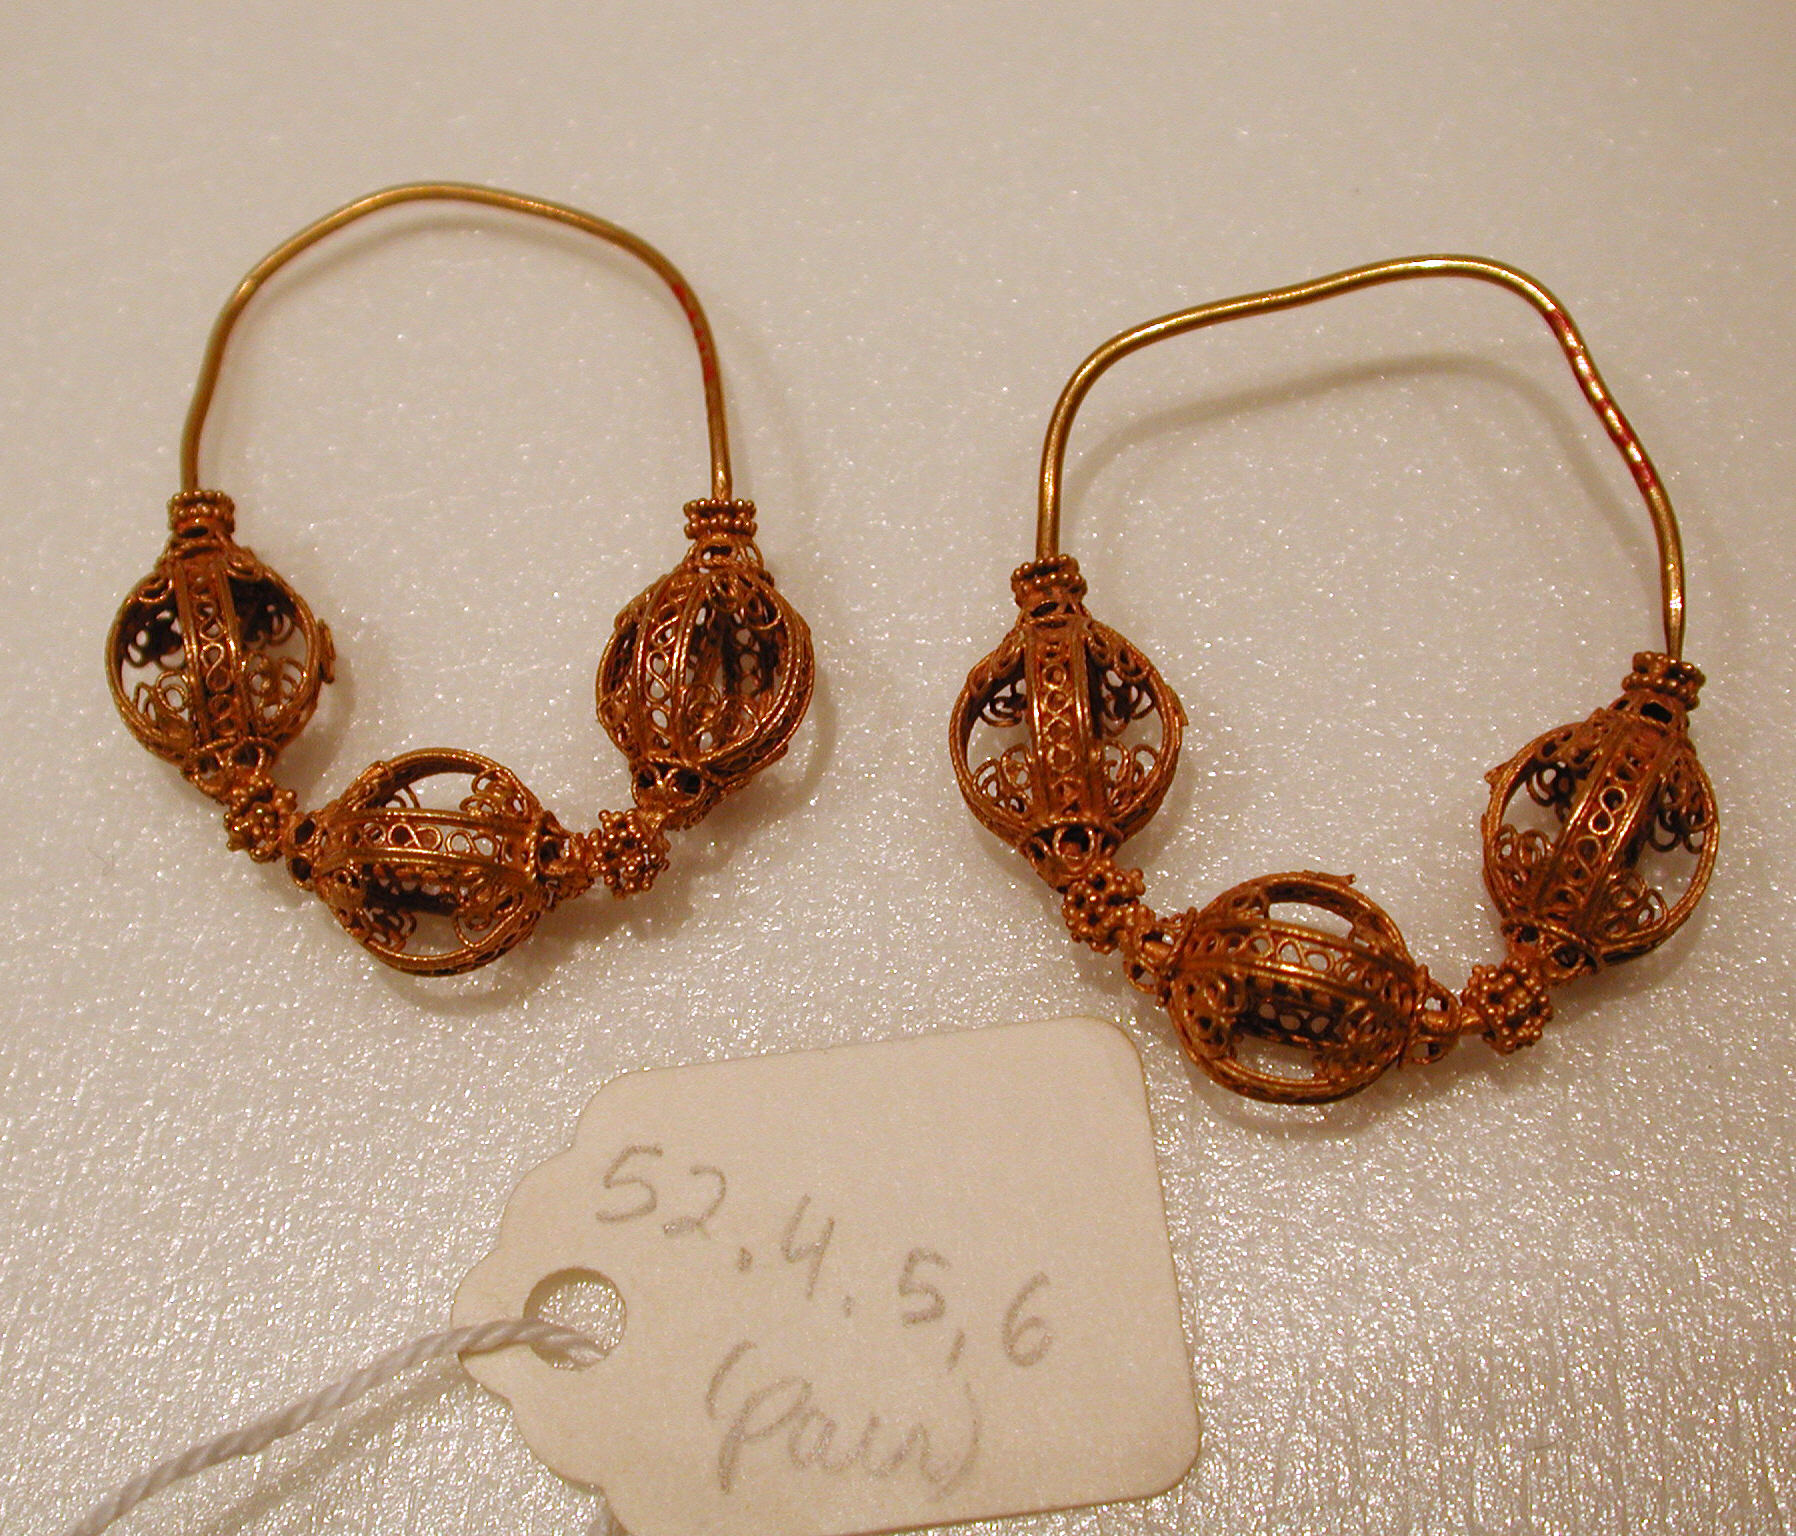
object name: earring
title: Earring, One of a Pair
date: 1101-1300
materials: gold, metal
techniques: filigree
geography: iran